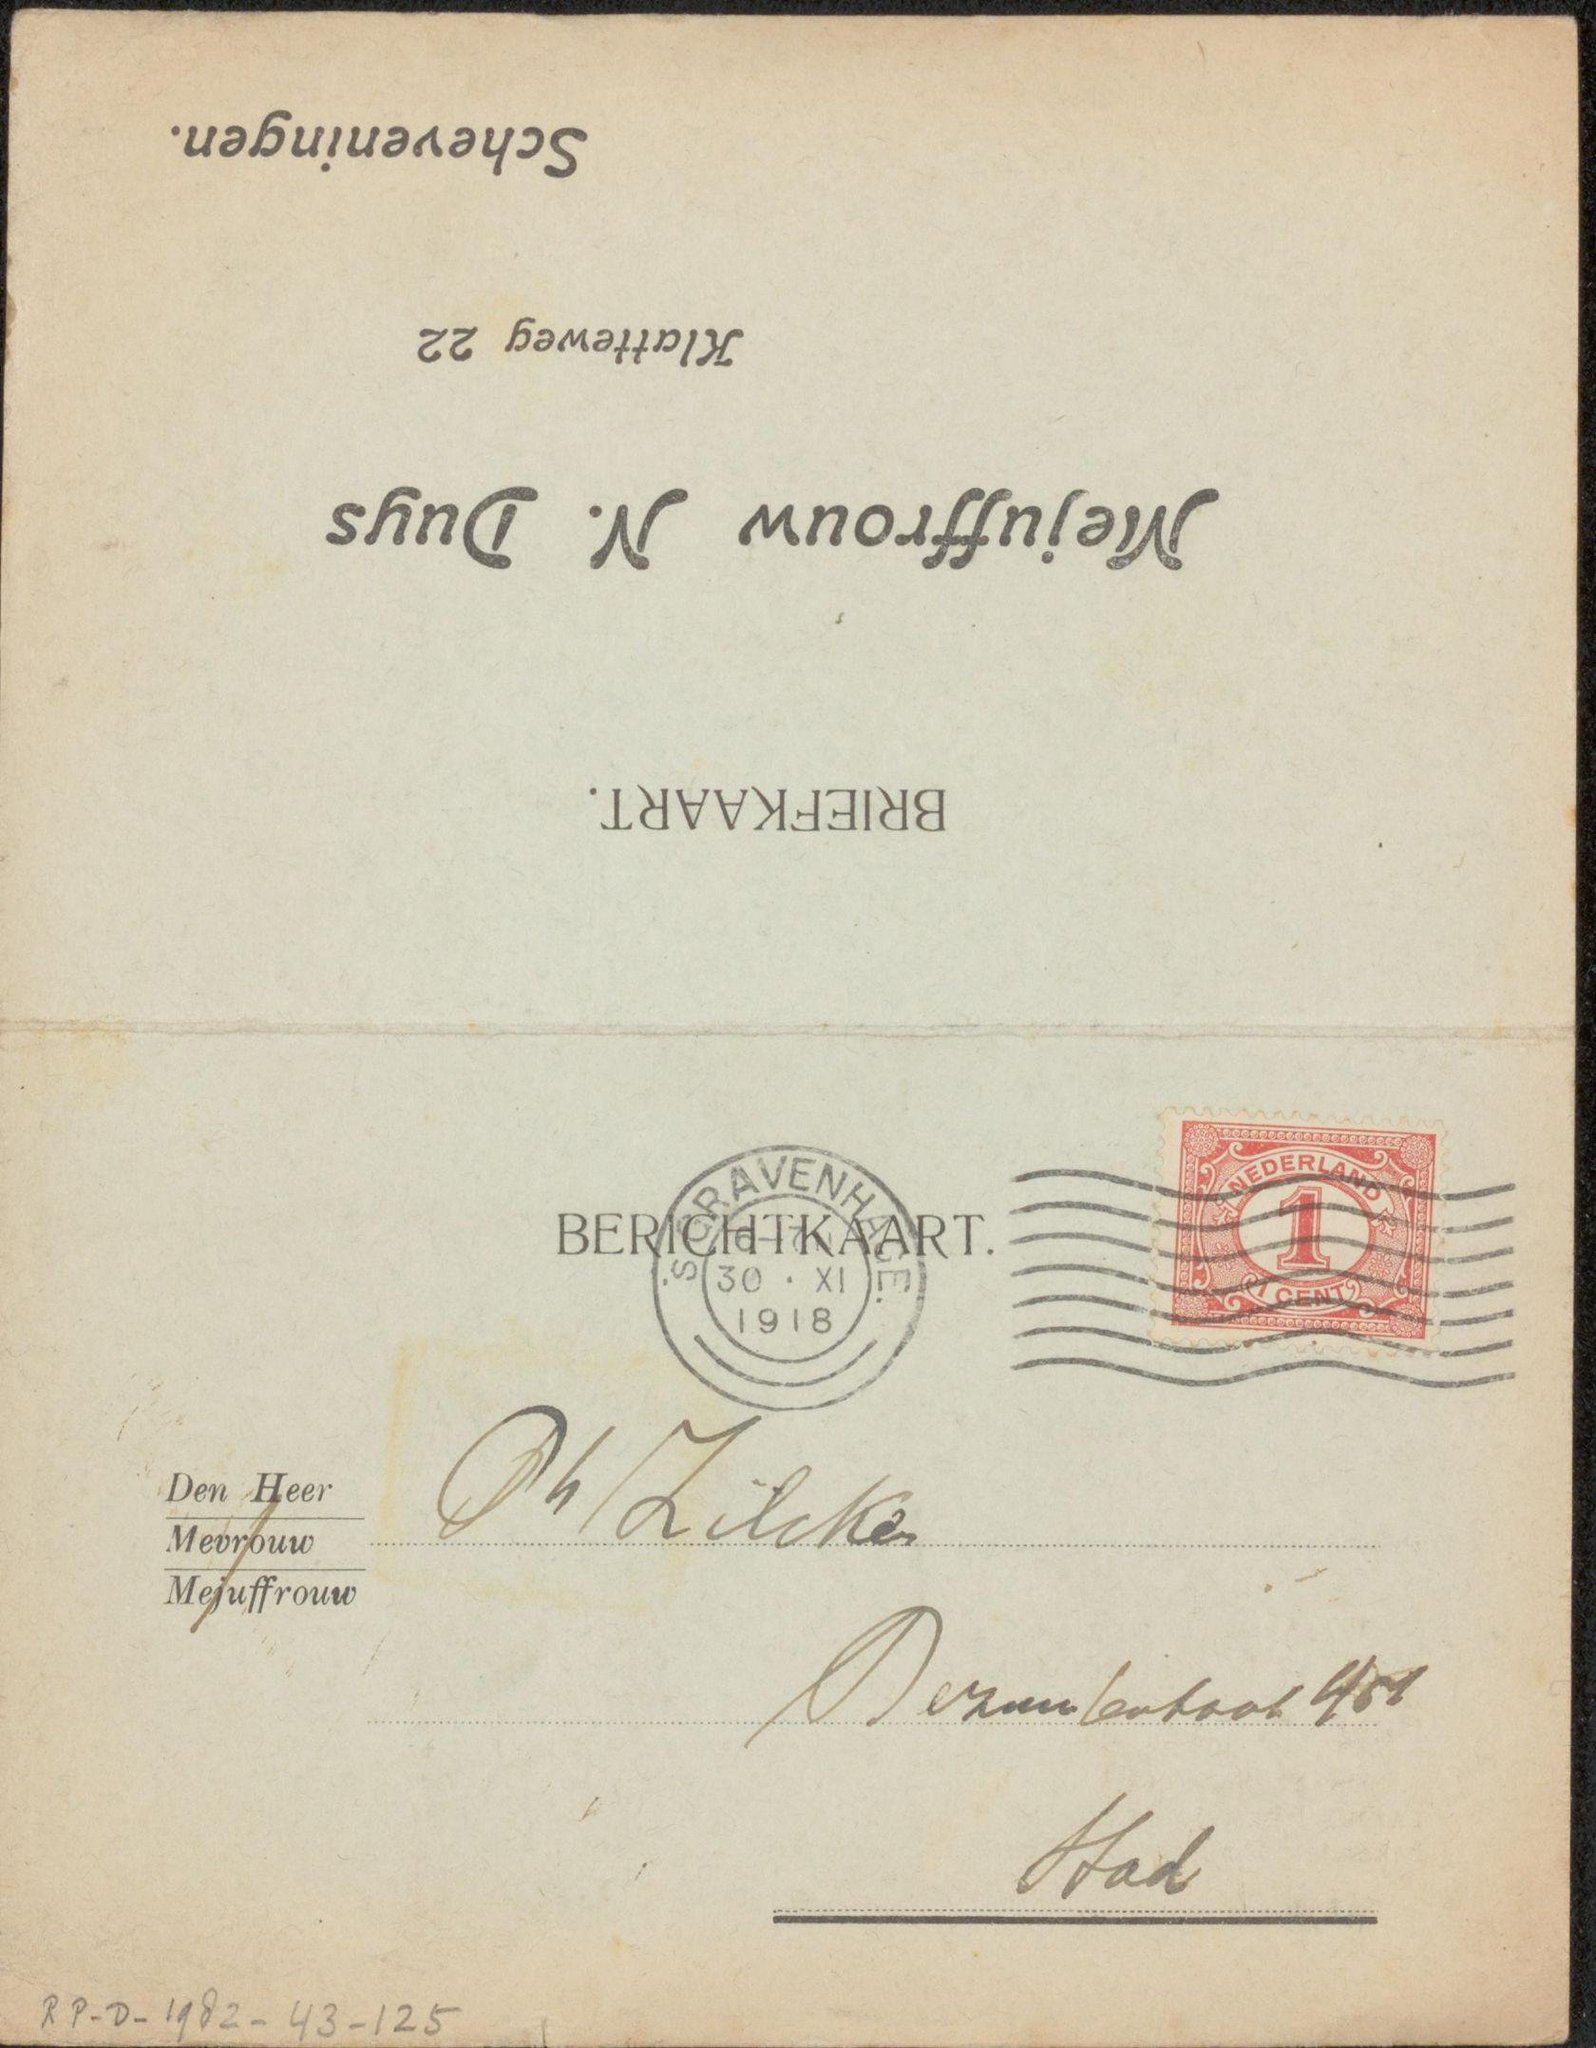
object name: postcard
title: Briefkaart aan Philip Zilcken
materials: cardboard, ink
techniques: pen, printing, writing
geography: the hague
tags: charles baudelaire, paris, paul verlaine, painter, philip zilcken